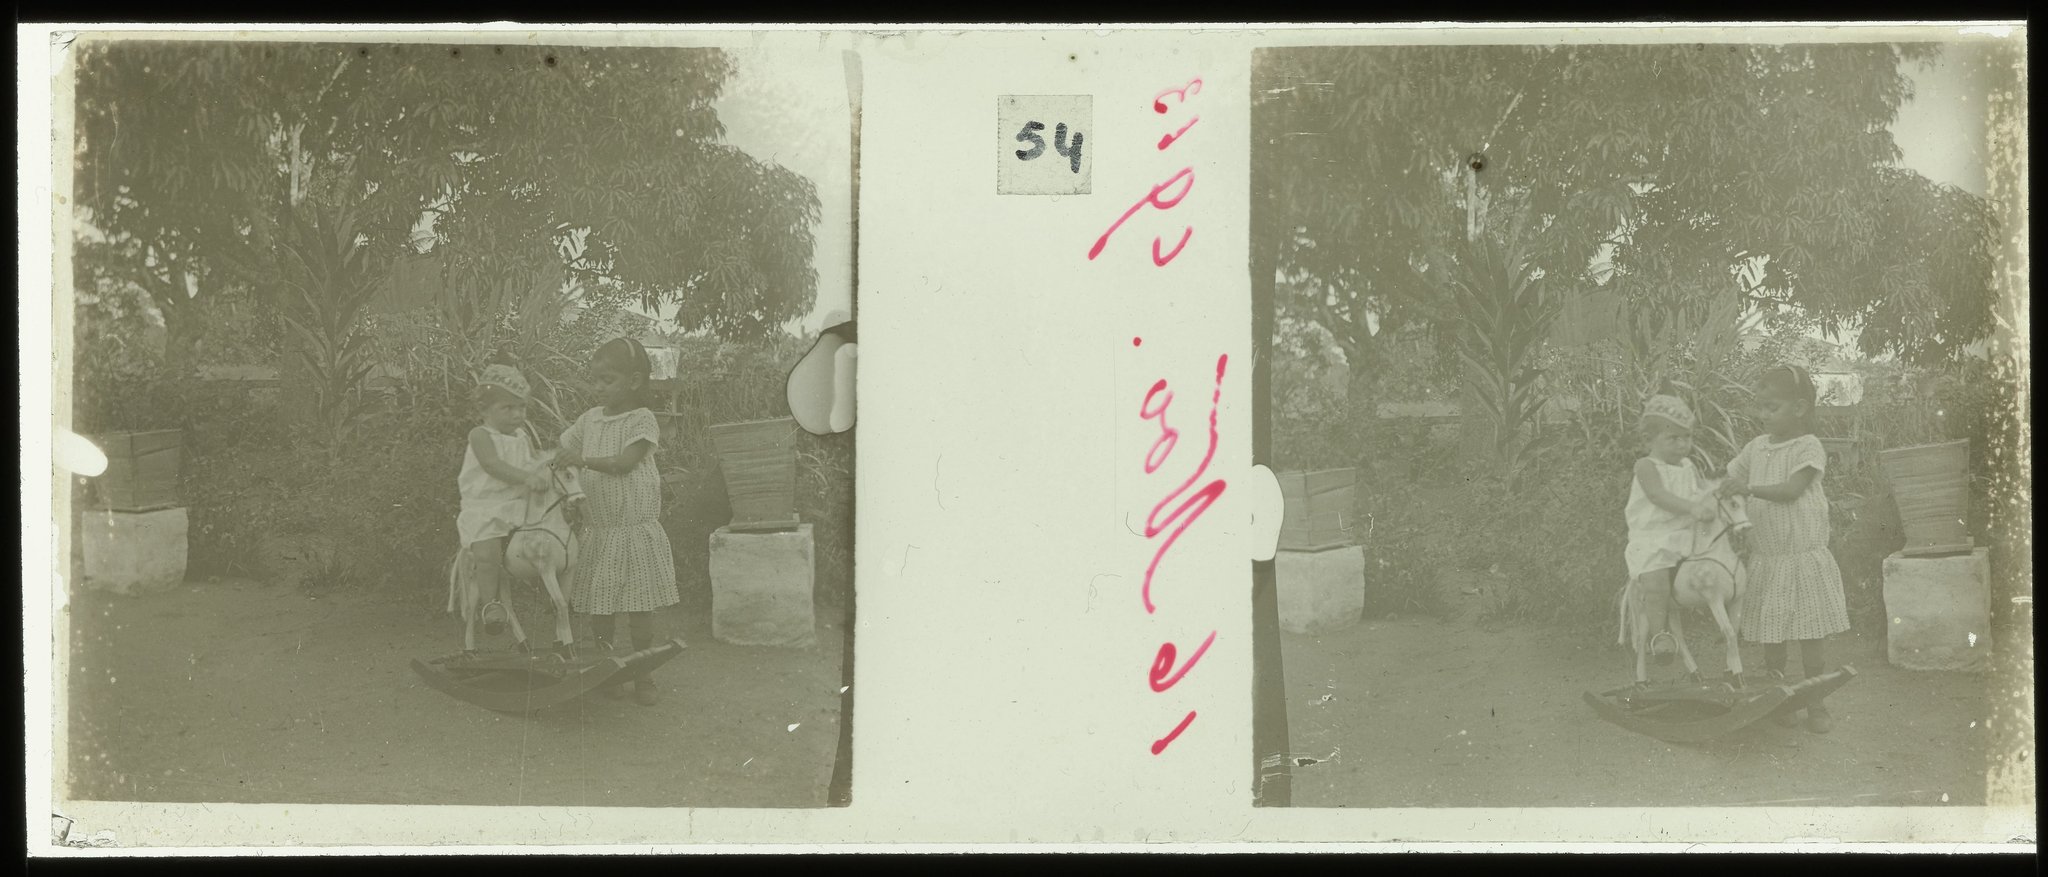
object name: stereograph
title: Plantage Accaribo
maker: theodoor brouwers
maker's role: amateurfotograaf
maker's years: 1874-1932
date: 1913-1930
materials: glass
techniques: photography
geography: suriname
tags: amsterdam, theodoor brouwers, plantation, suriname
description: In de periode 1911-1932 woonde op plantage Accaribo in Suriname de familie Brouwers van wie de foto's afkomstig zijn. Rond 1910 vond Theodoor Brouwers werk op plantage Accaribo. In 1929 werd hij eigenaar van de plantage. Op Accaribo werden in zijn tijd bananen geproduceerd en wat koffie.